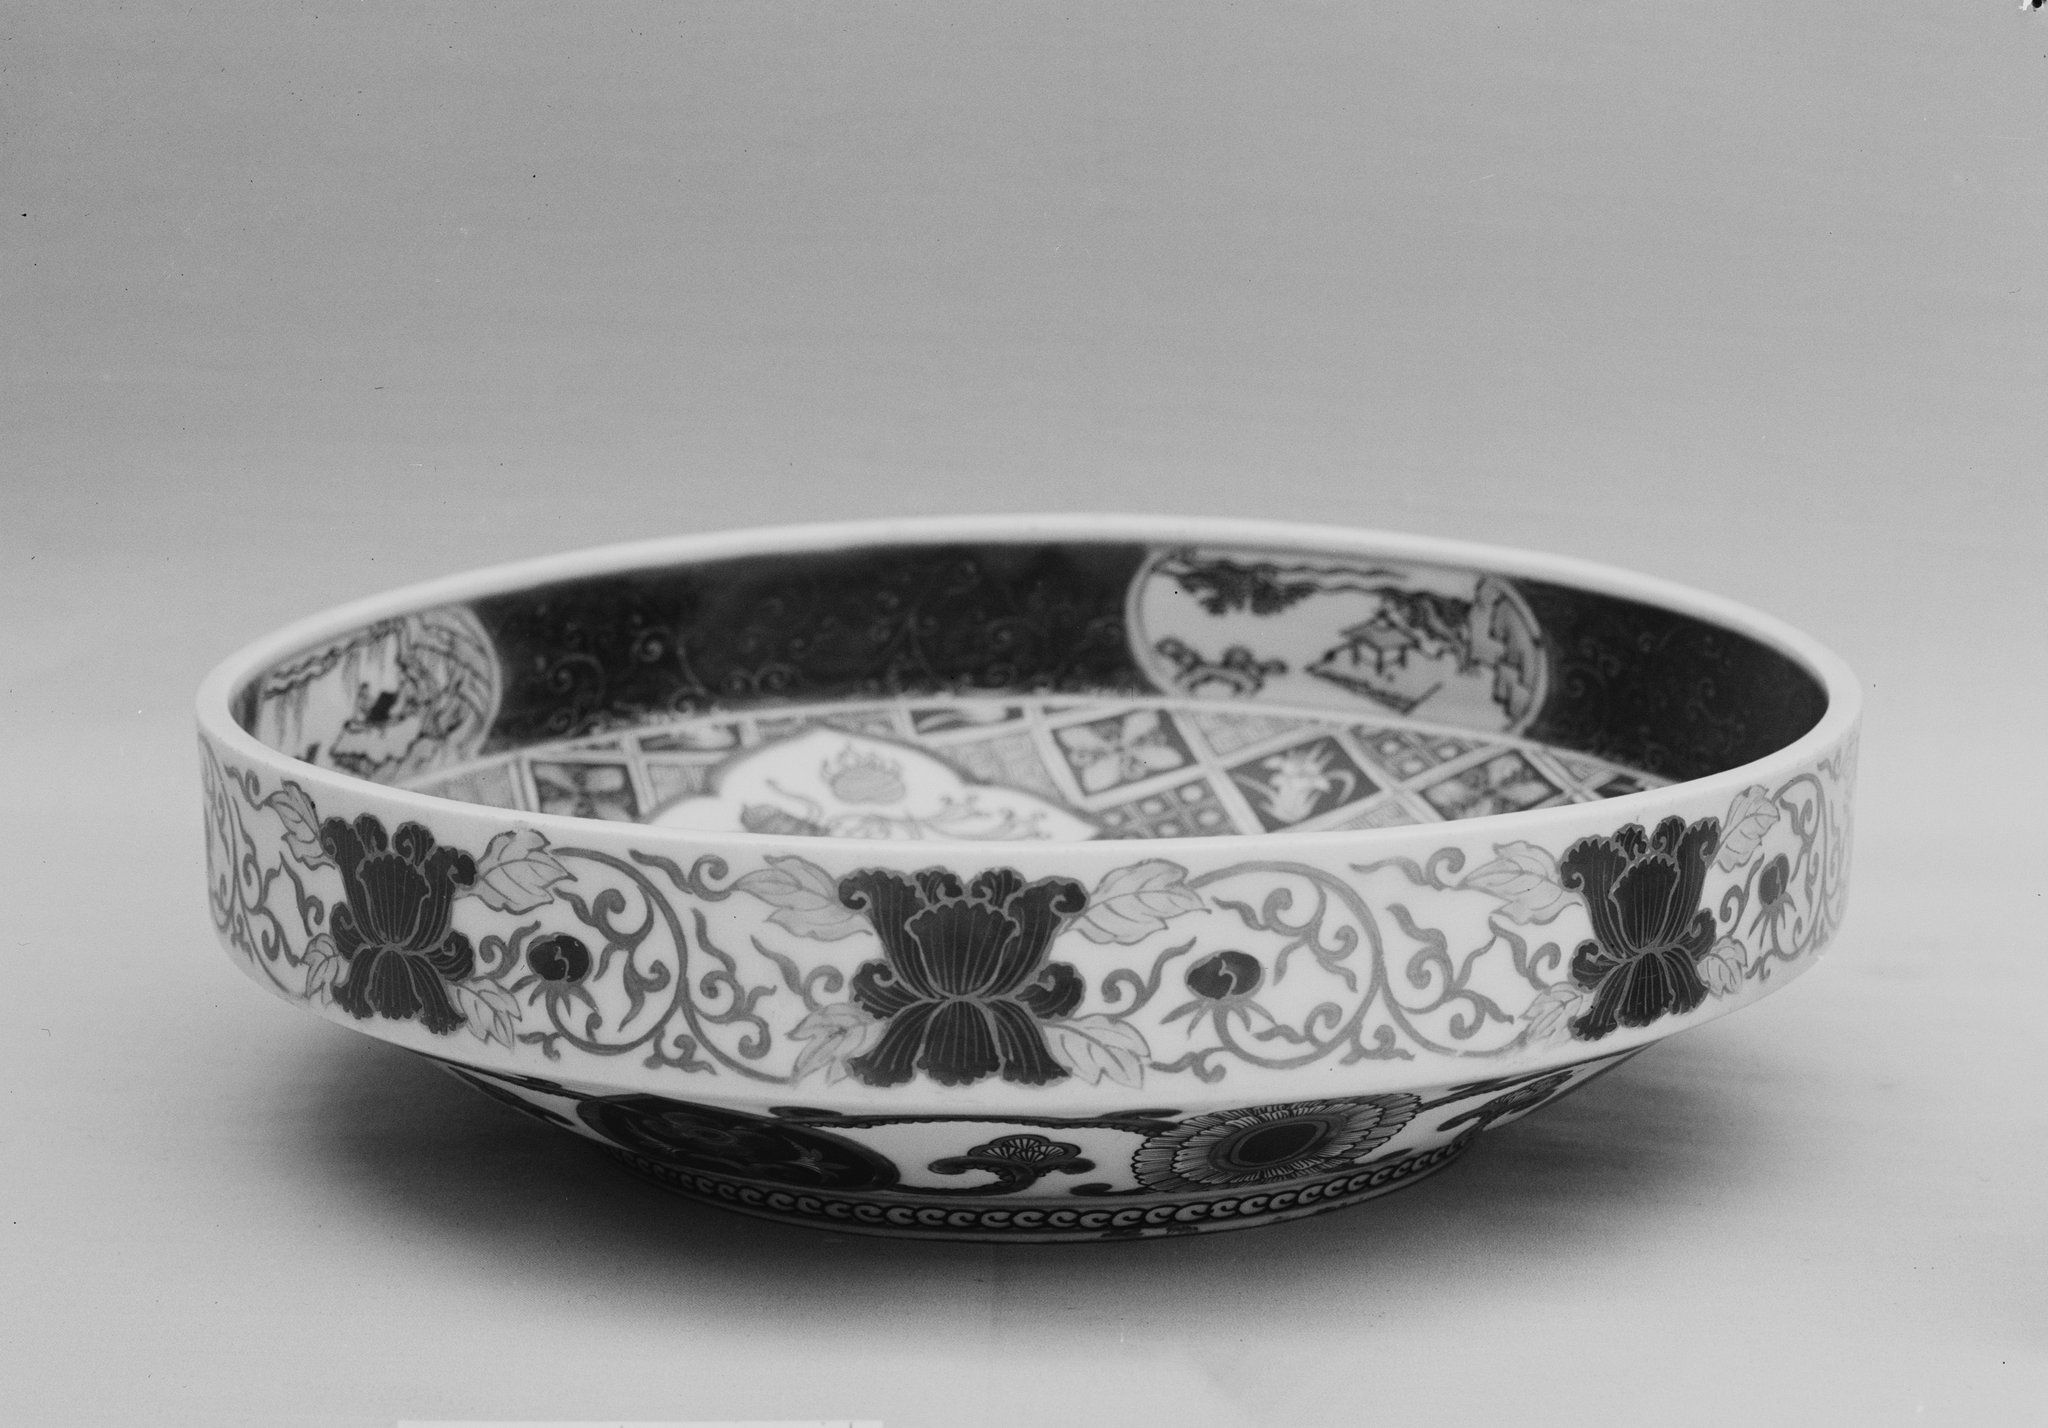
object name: dish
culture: japanese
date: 1750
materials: enamel, glaze, porcelain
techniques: polychrome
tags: flowers,leaves